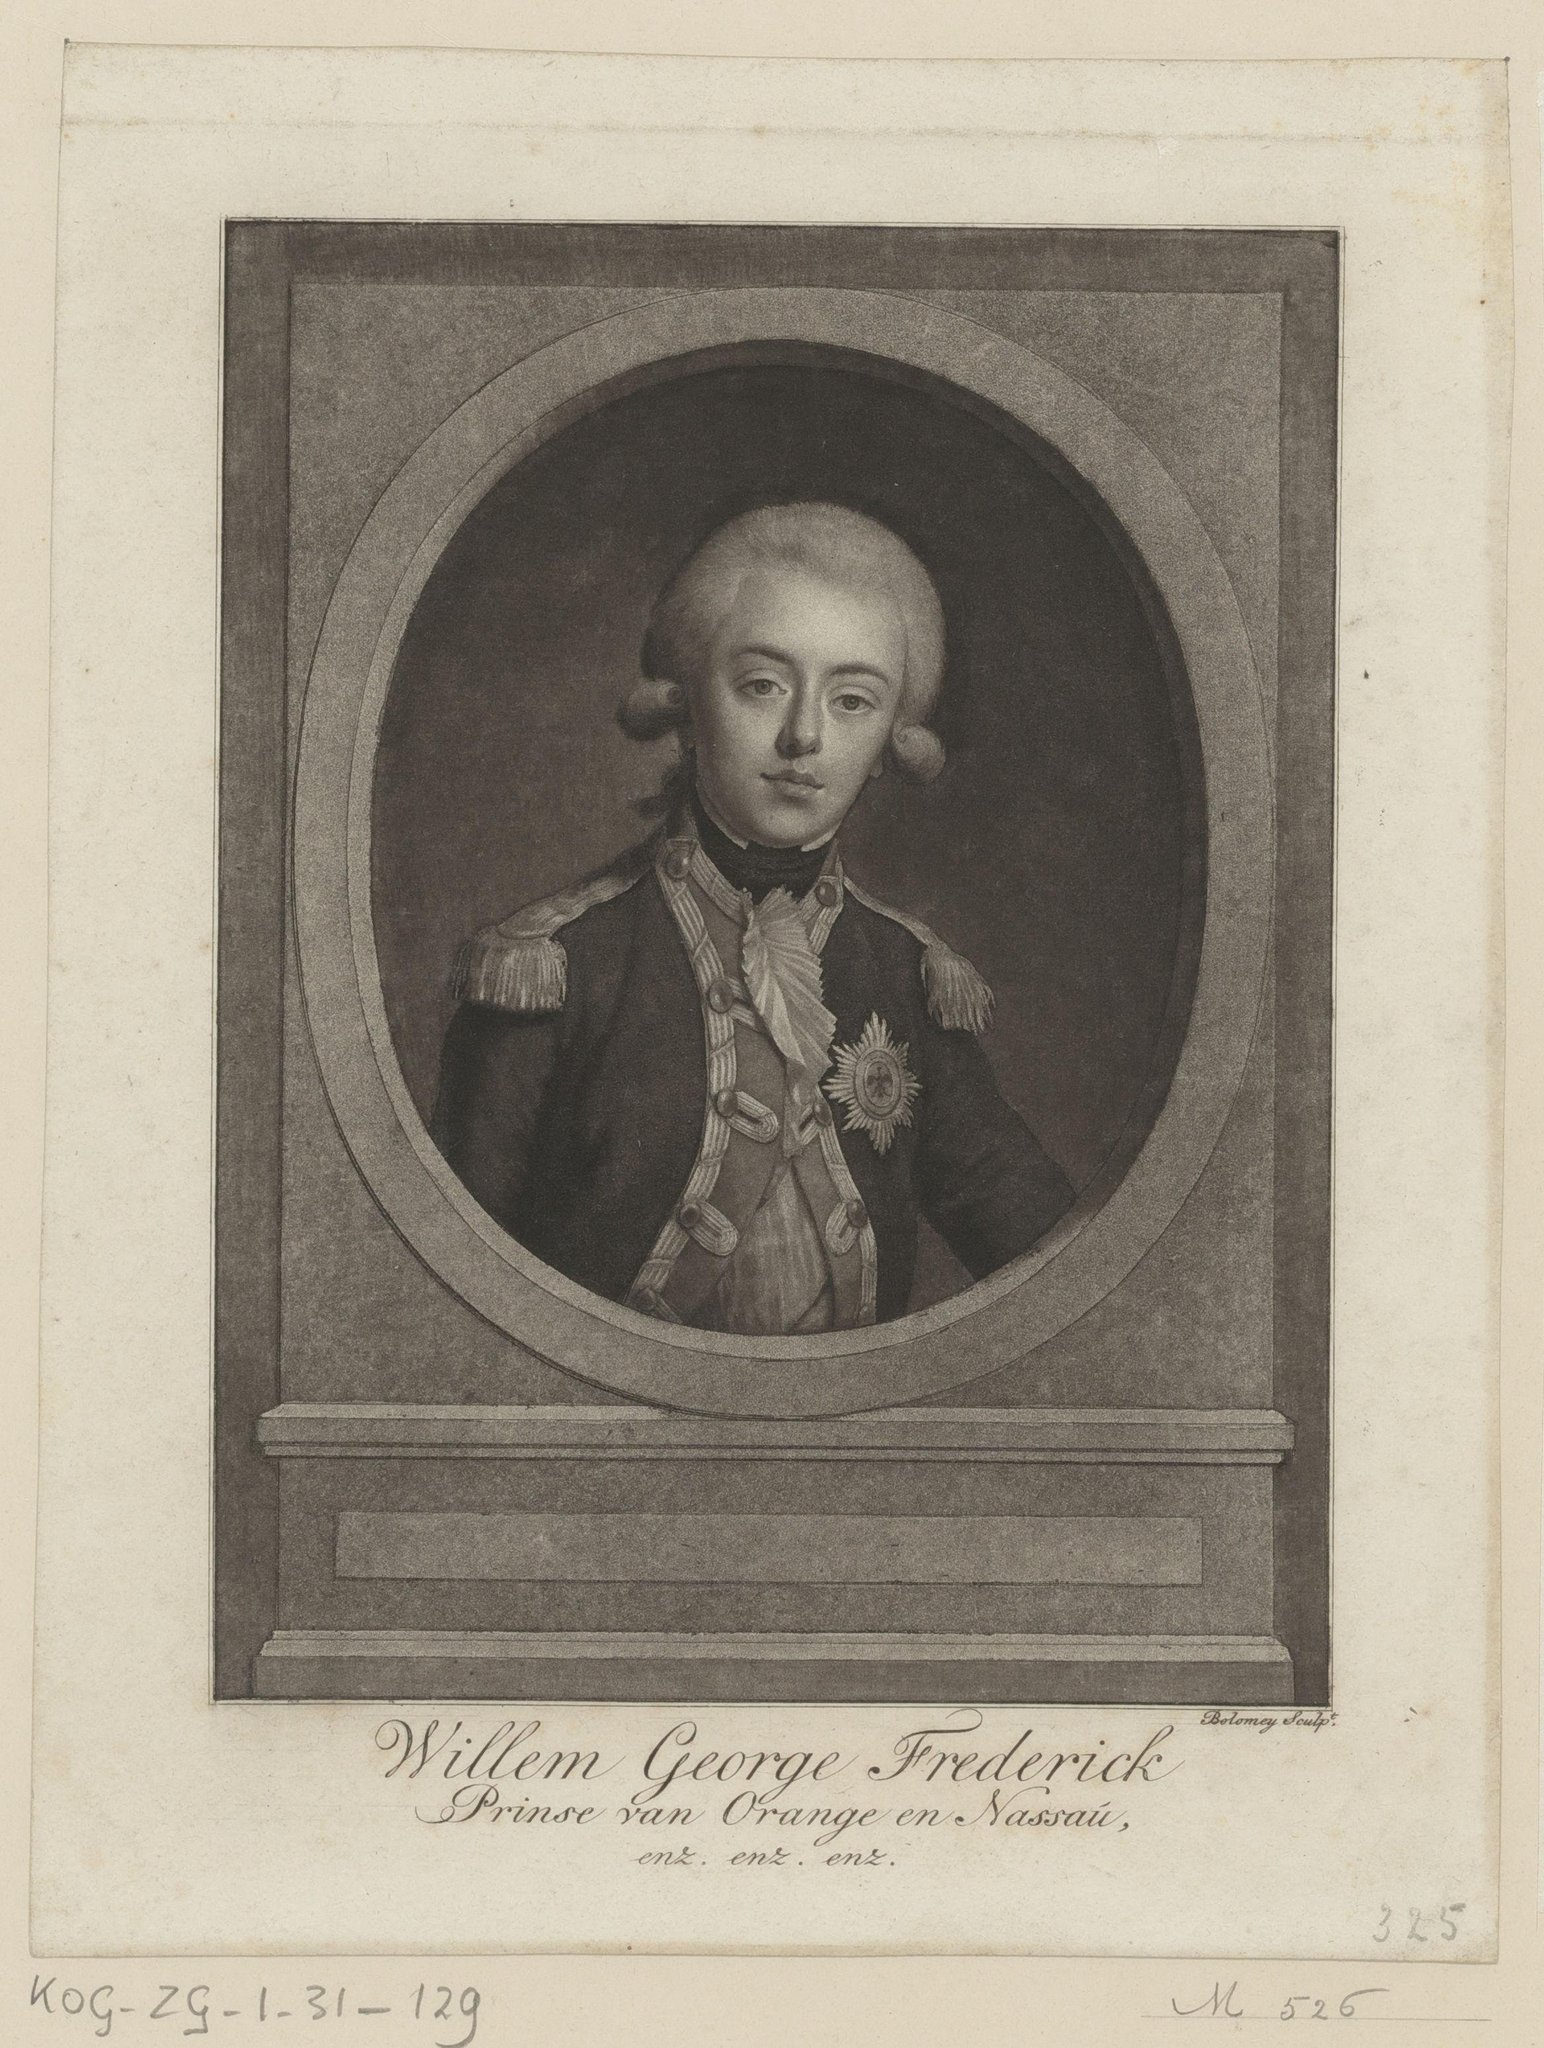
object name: print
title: Portret van Frederik, prins van Oranje-Nassau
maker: benjamin samuel bolomey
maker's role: print maker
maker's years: 1739-1819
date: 1790-1819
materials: paper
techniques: aquatint, etching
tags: willem george frederik (prins van oranje-nassau), knighthood order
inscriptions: stamp, collector's mark: Lugt 1641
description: Onderwerpsrubrieken binnen de Atlas Zeden en Gewoonten: Portretten, Portretten van Vorsten uit het huis van Oranje, Niet regeerende Vorsten.